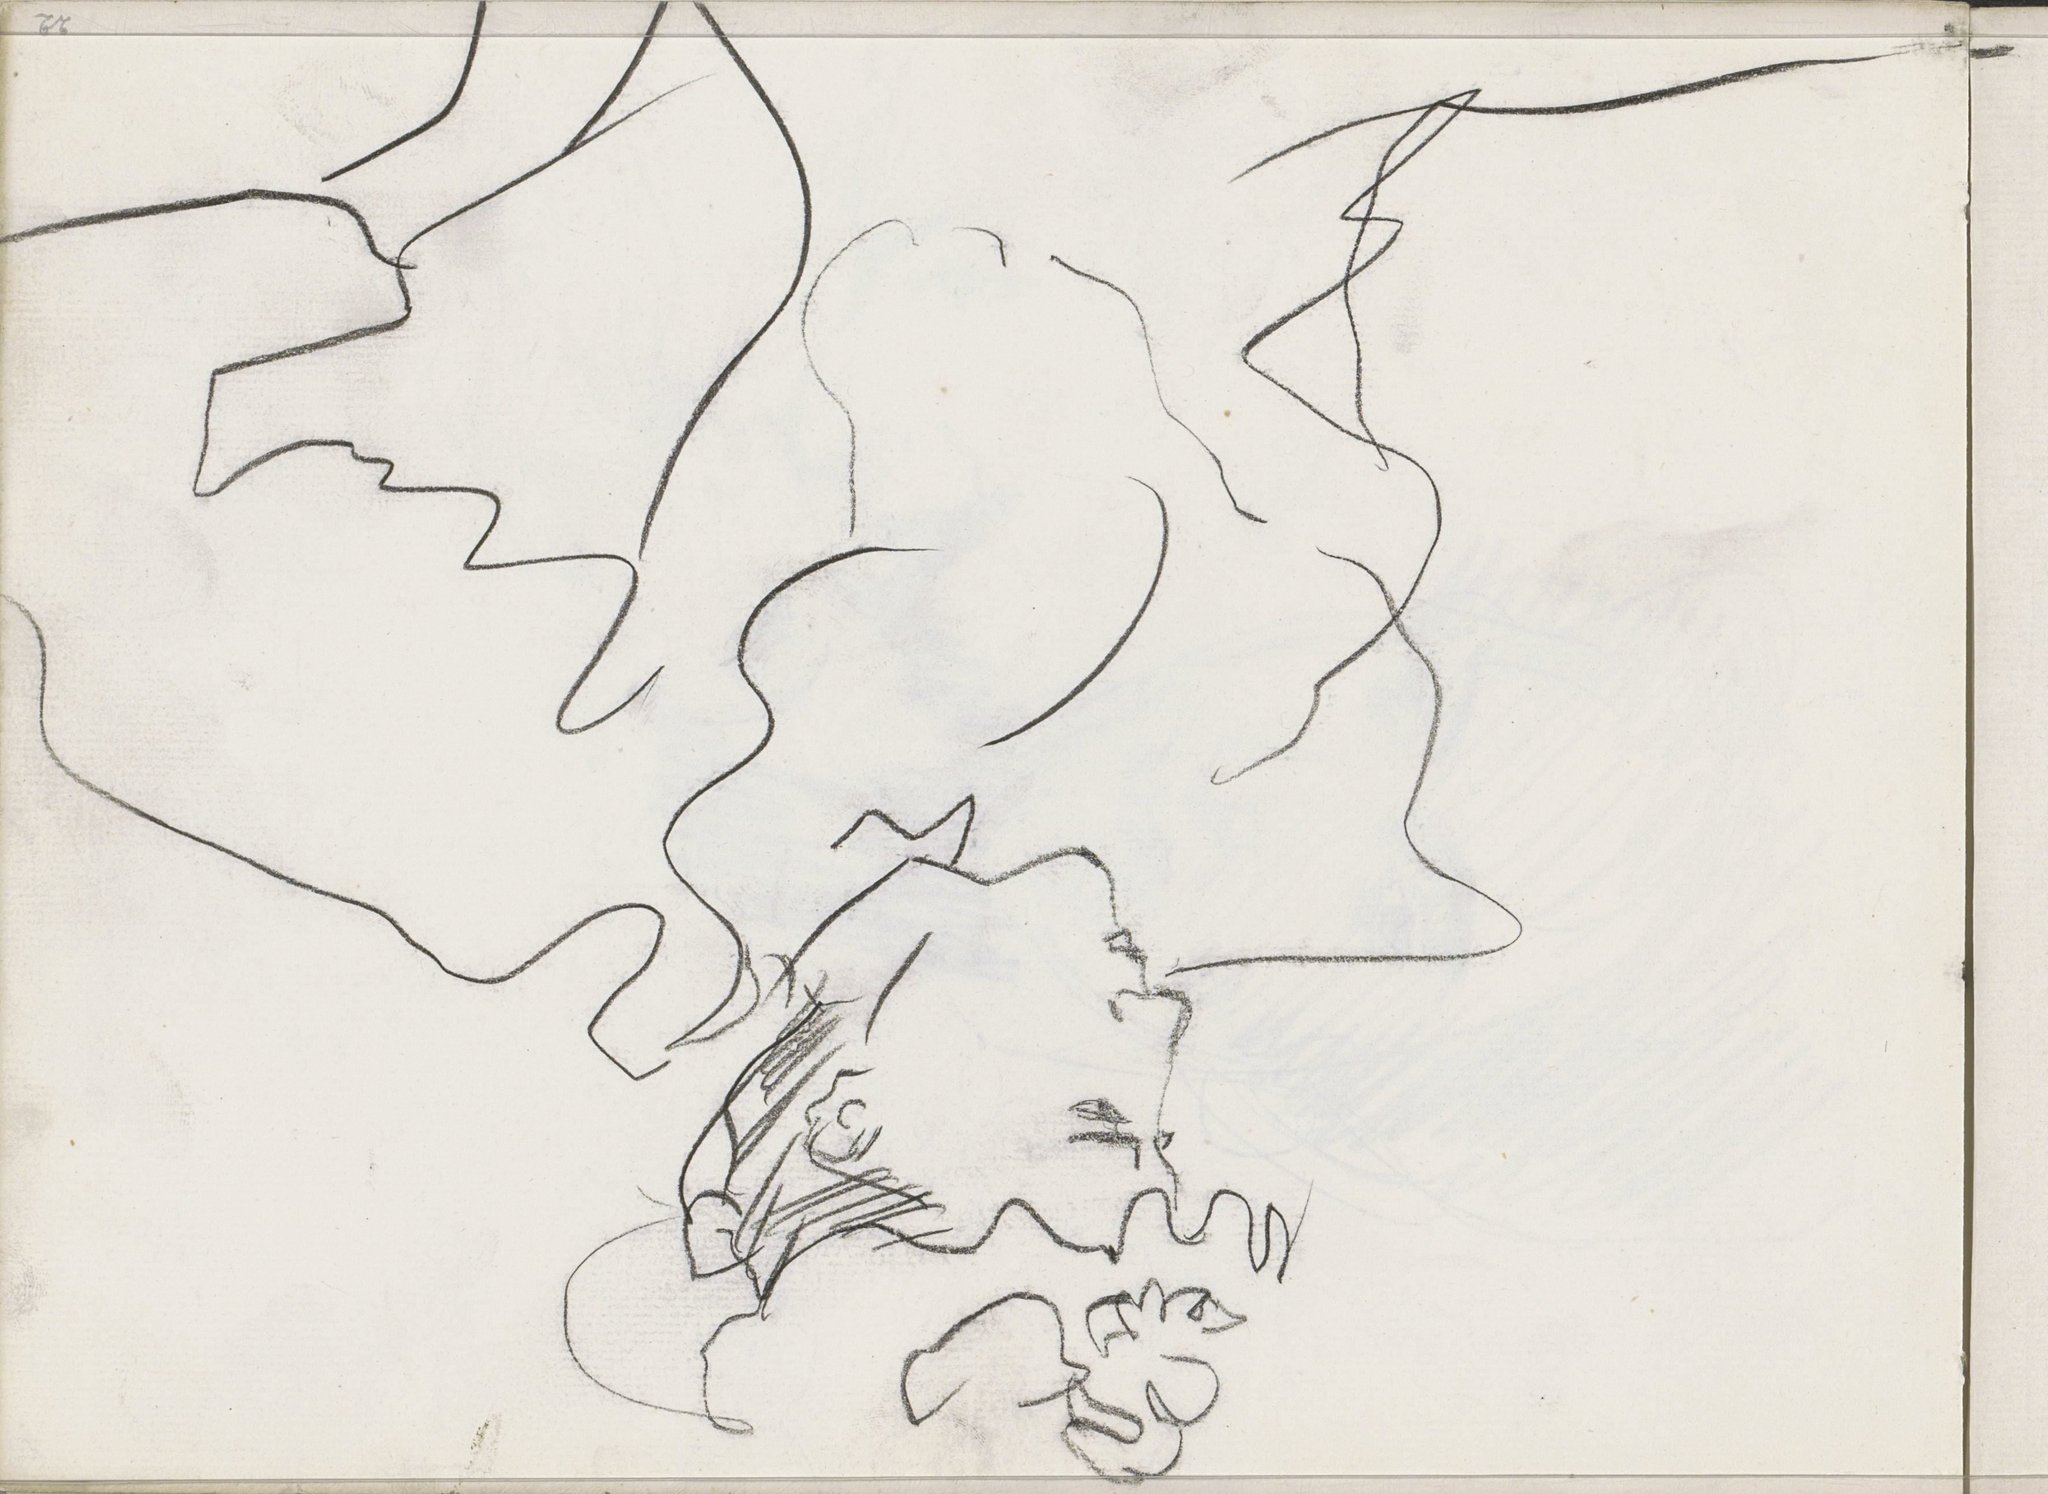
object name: sketchbook leaf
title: Vrouw met hoed, mogelijk zittend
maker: isaac israels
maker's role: draughtsman, painter, print maker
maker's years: 1865-1934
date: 1875-1934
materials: chalk, paper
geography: the hague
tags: adult woman (+ sitting)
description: Blad 17 verso uit schetsboek XXI met 19 bladen.